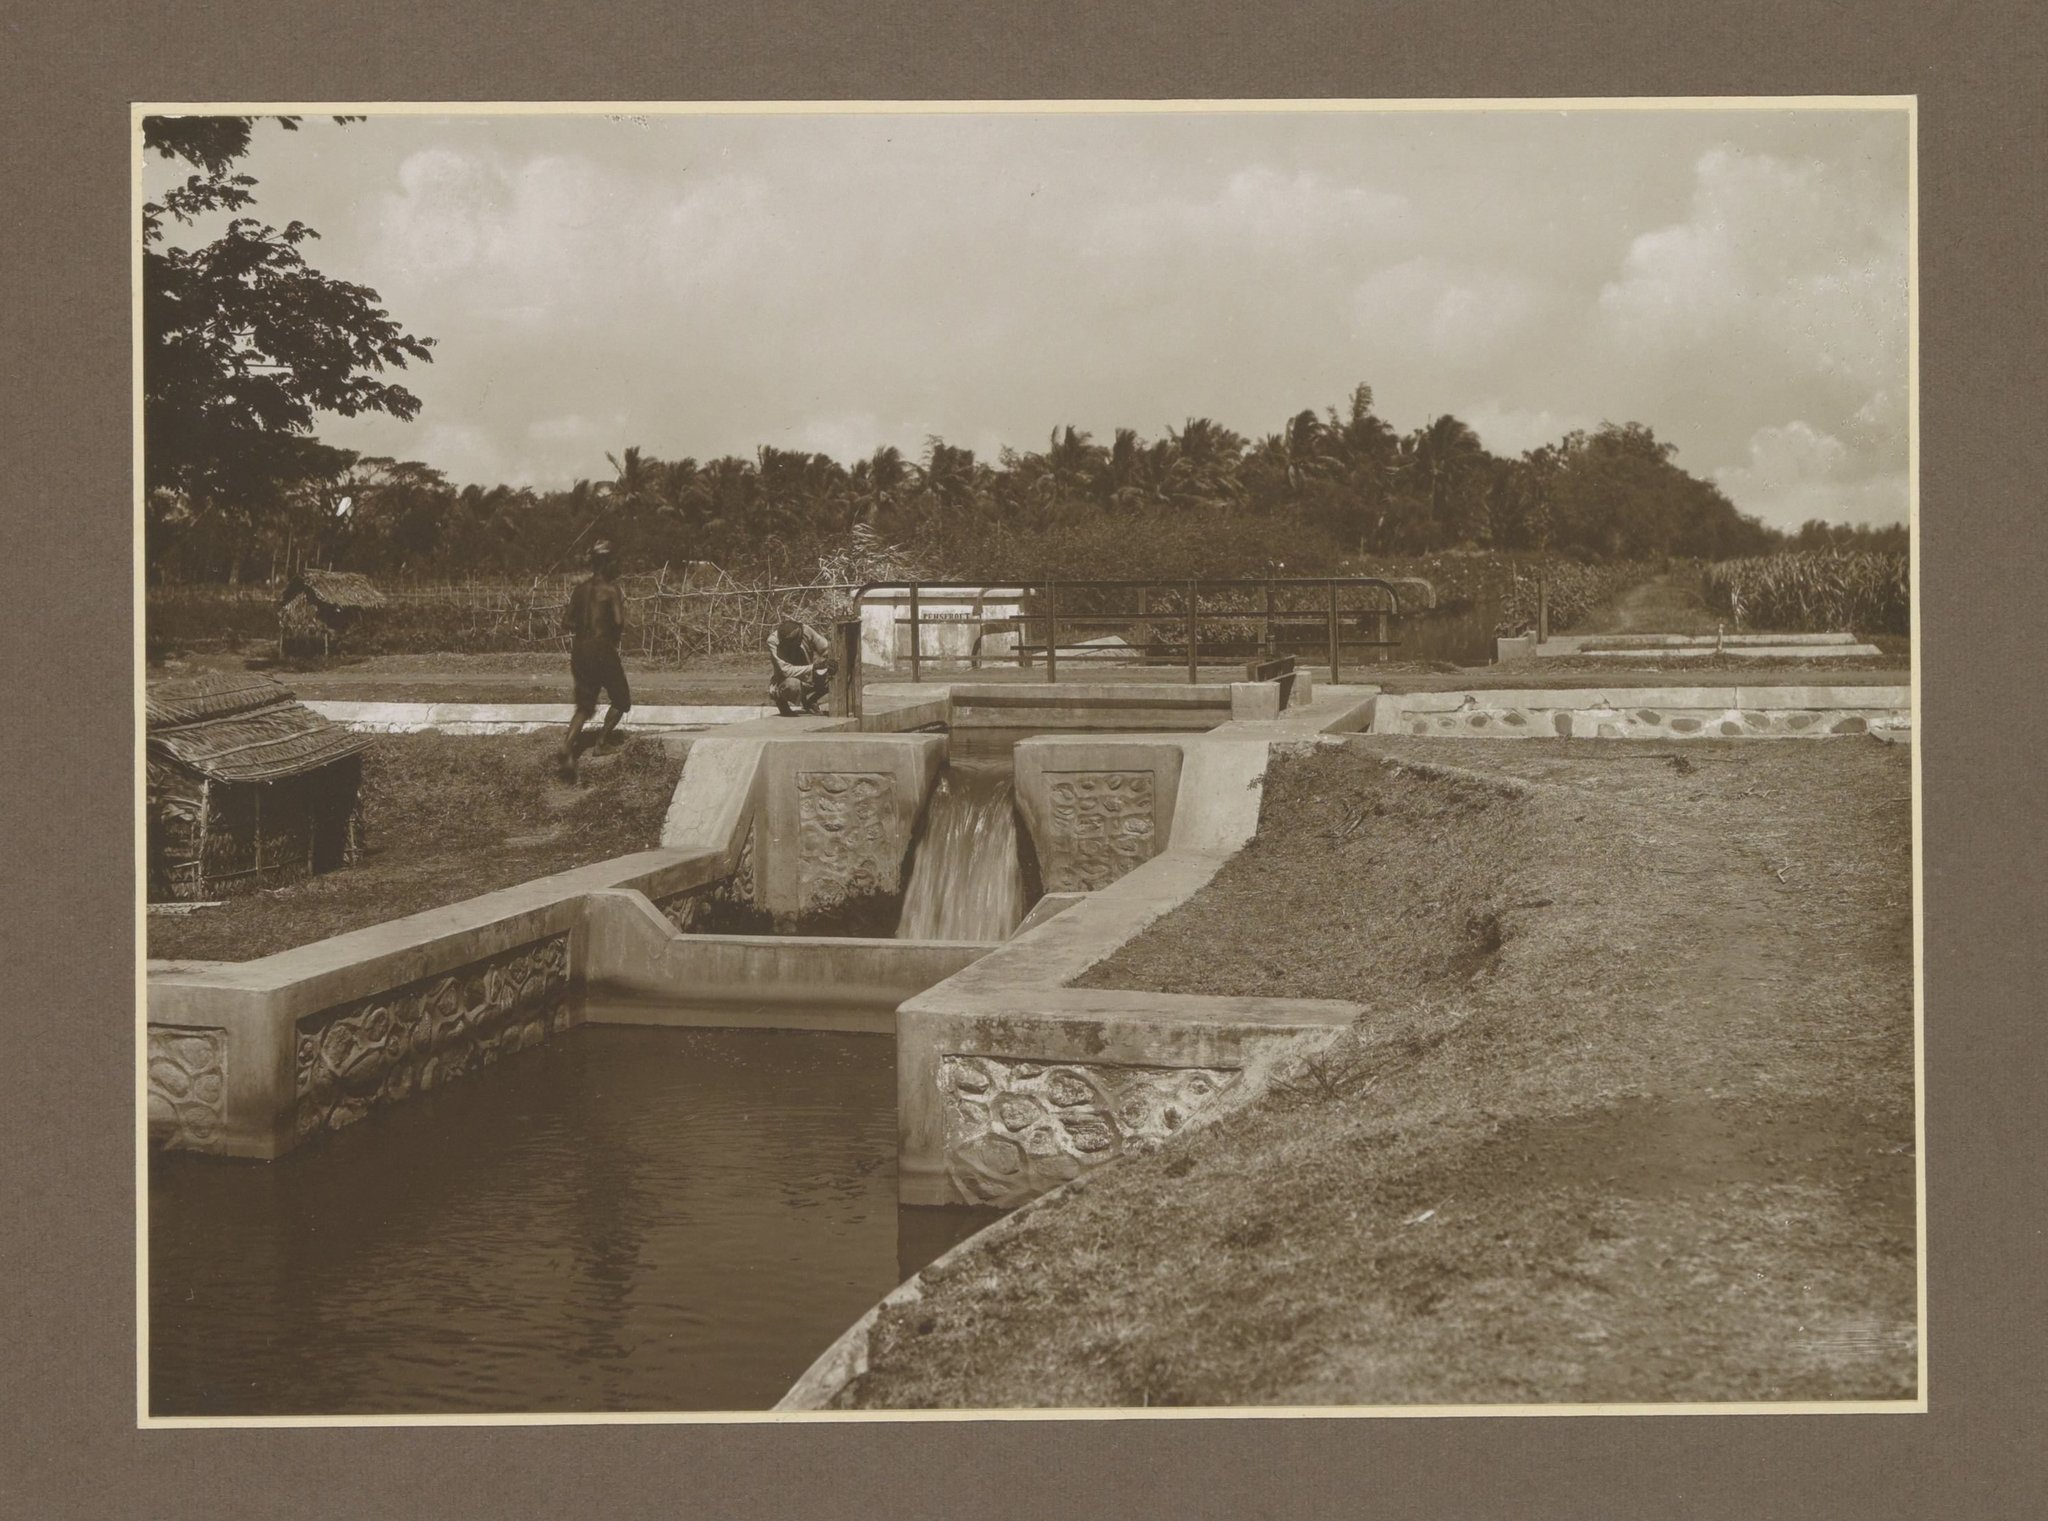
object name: photograph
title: Indische mannen bij een waterwerk bij suikerfabriek Ngandjoek op Java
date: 1925-1930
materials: cardboard, paper, photographic support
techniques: gelatin silver print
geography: nganjuk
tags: sluice, weir, plantation, small canal, ditch, plants and herbs: sugarcane, sugar, dutch east indies, the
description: Onderdeel van Fotoalbum met opnames van vier suikerfabrieken op Java.